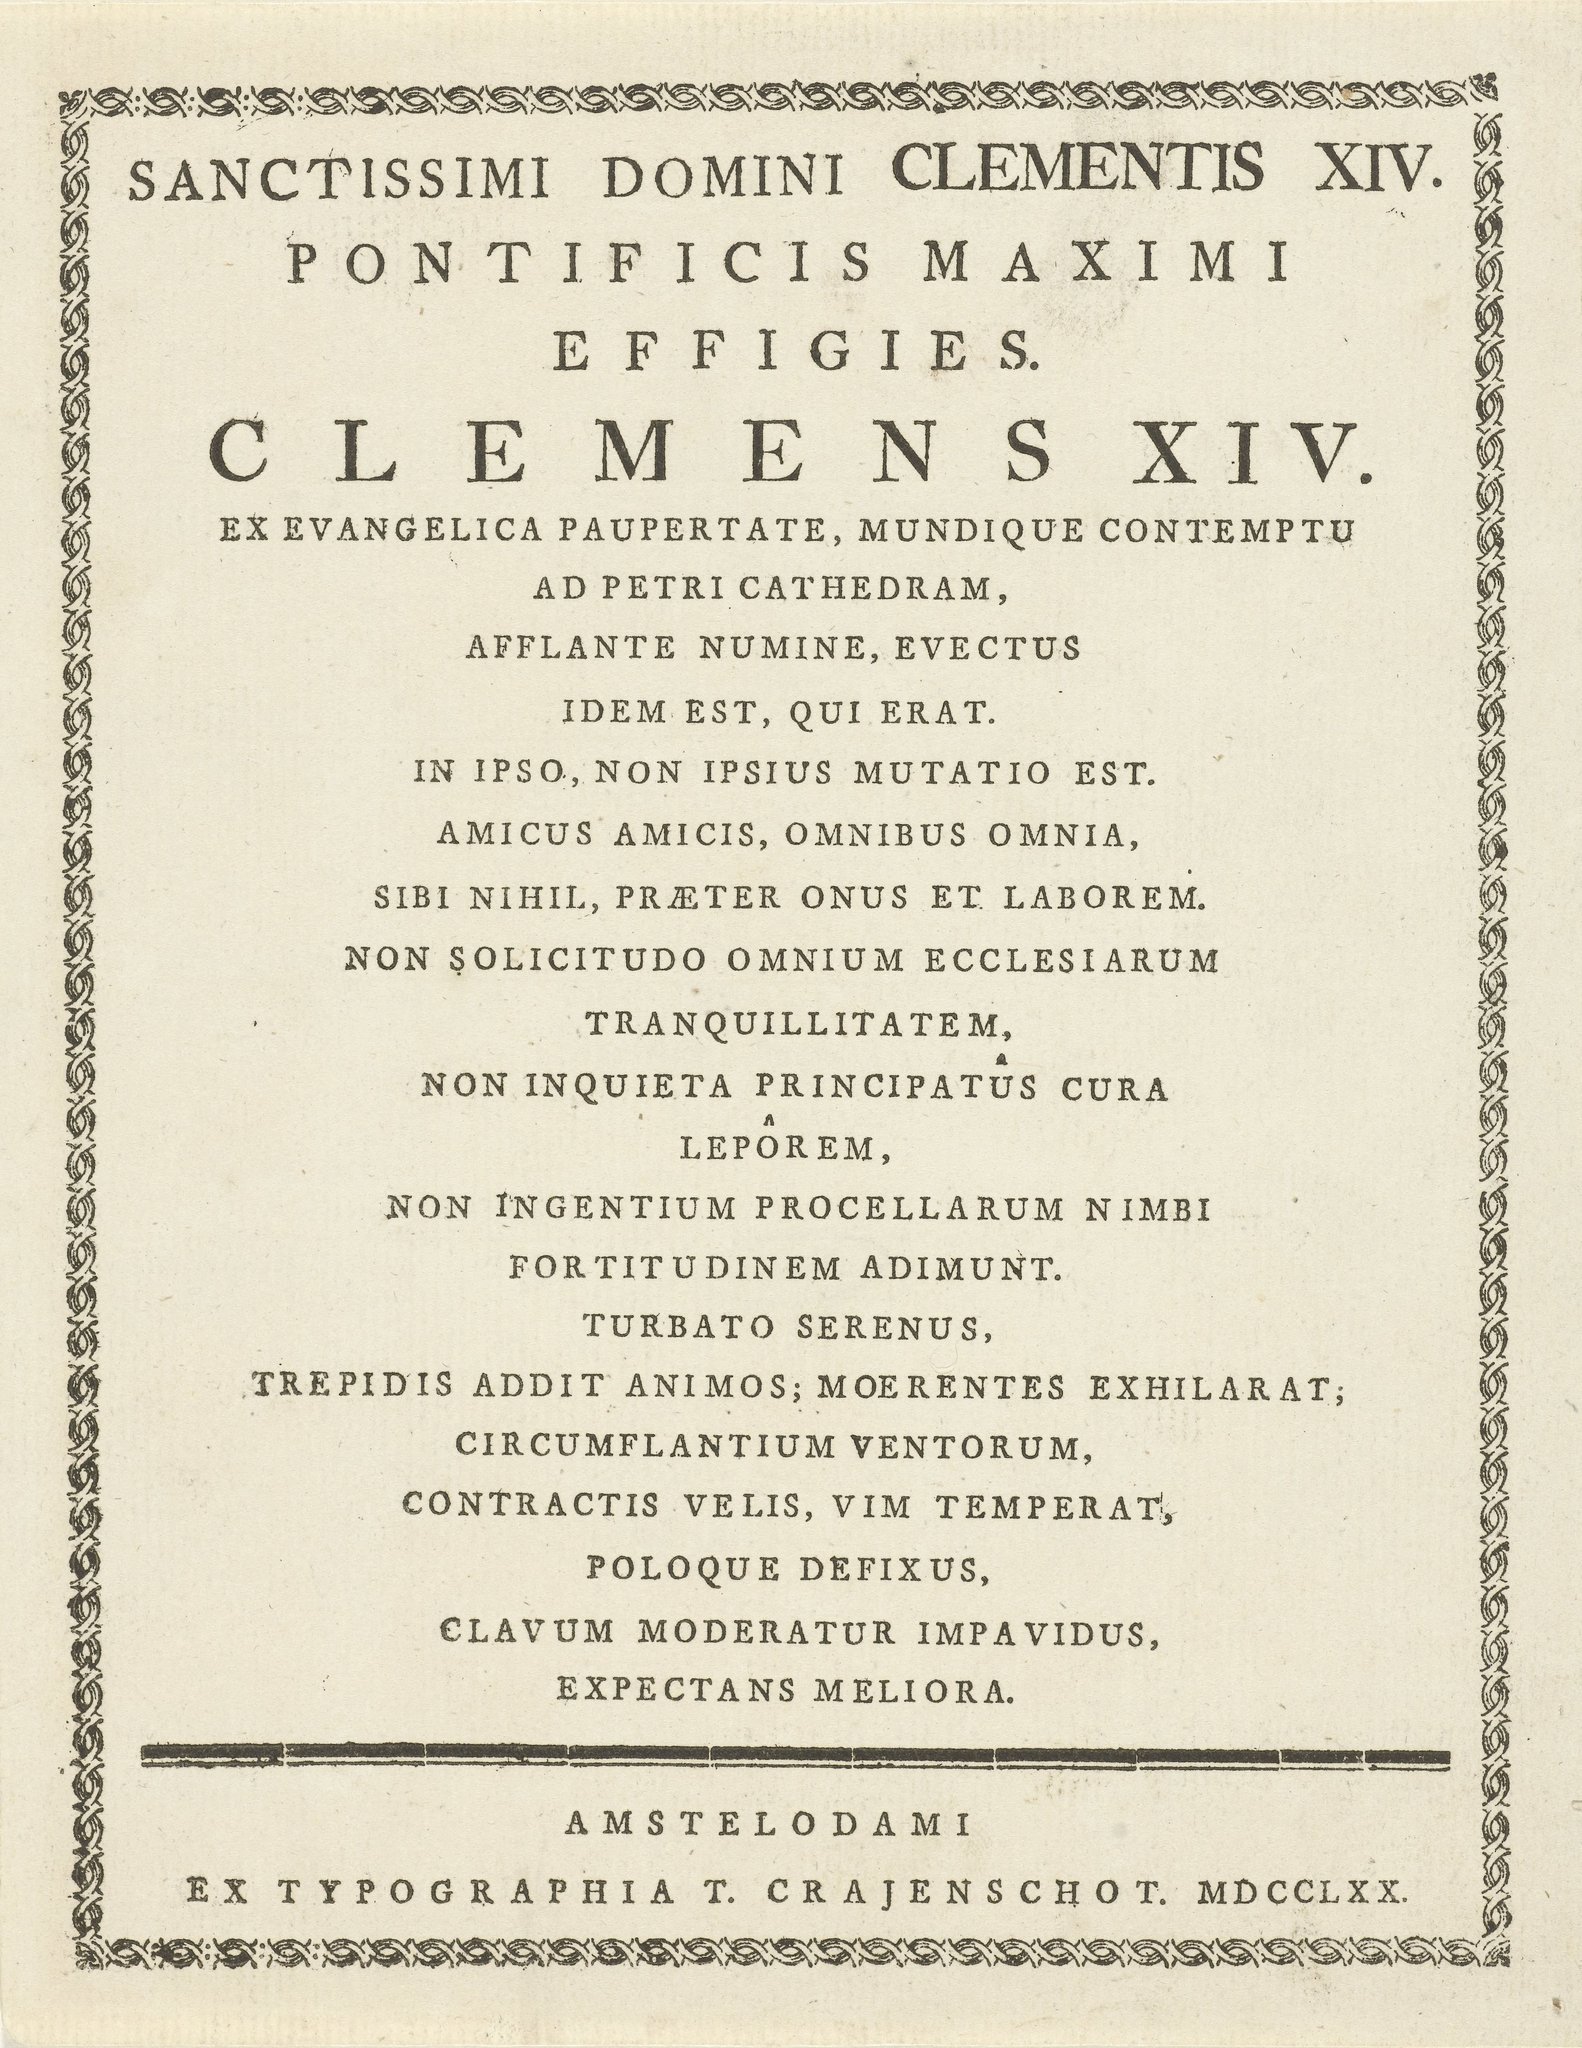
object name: text sheet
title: Tekstblad bij portret van paus Clement XIV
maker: theodorus crajenschot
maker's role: publisher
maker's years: 1717-1803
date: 1770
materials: paper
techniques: letterpress printing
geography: amsterdam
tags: rome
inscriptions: collector's mark: Lugt 2228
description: Tekstblad bij portret van paus Clement XIV met opschrift in Latijn.